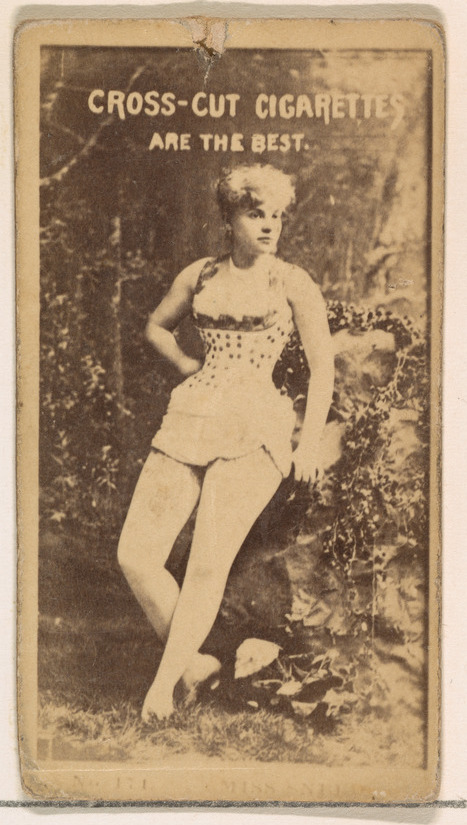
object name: print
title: Card Number 171, from the Actors and Actresses series (N145-2) issued by Duke Sons & Co. to promote Cross Cut Cigarettes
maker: w. duke, sons & co.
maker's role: publisher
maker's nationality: american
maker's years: 1870-1920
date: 1880-1889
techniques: albumen silver print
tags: portraits,women,actresses